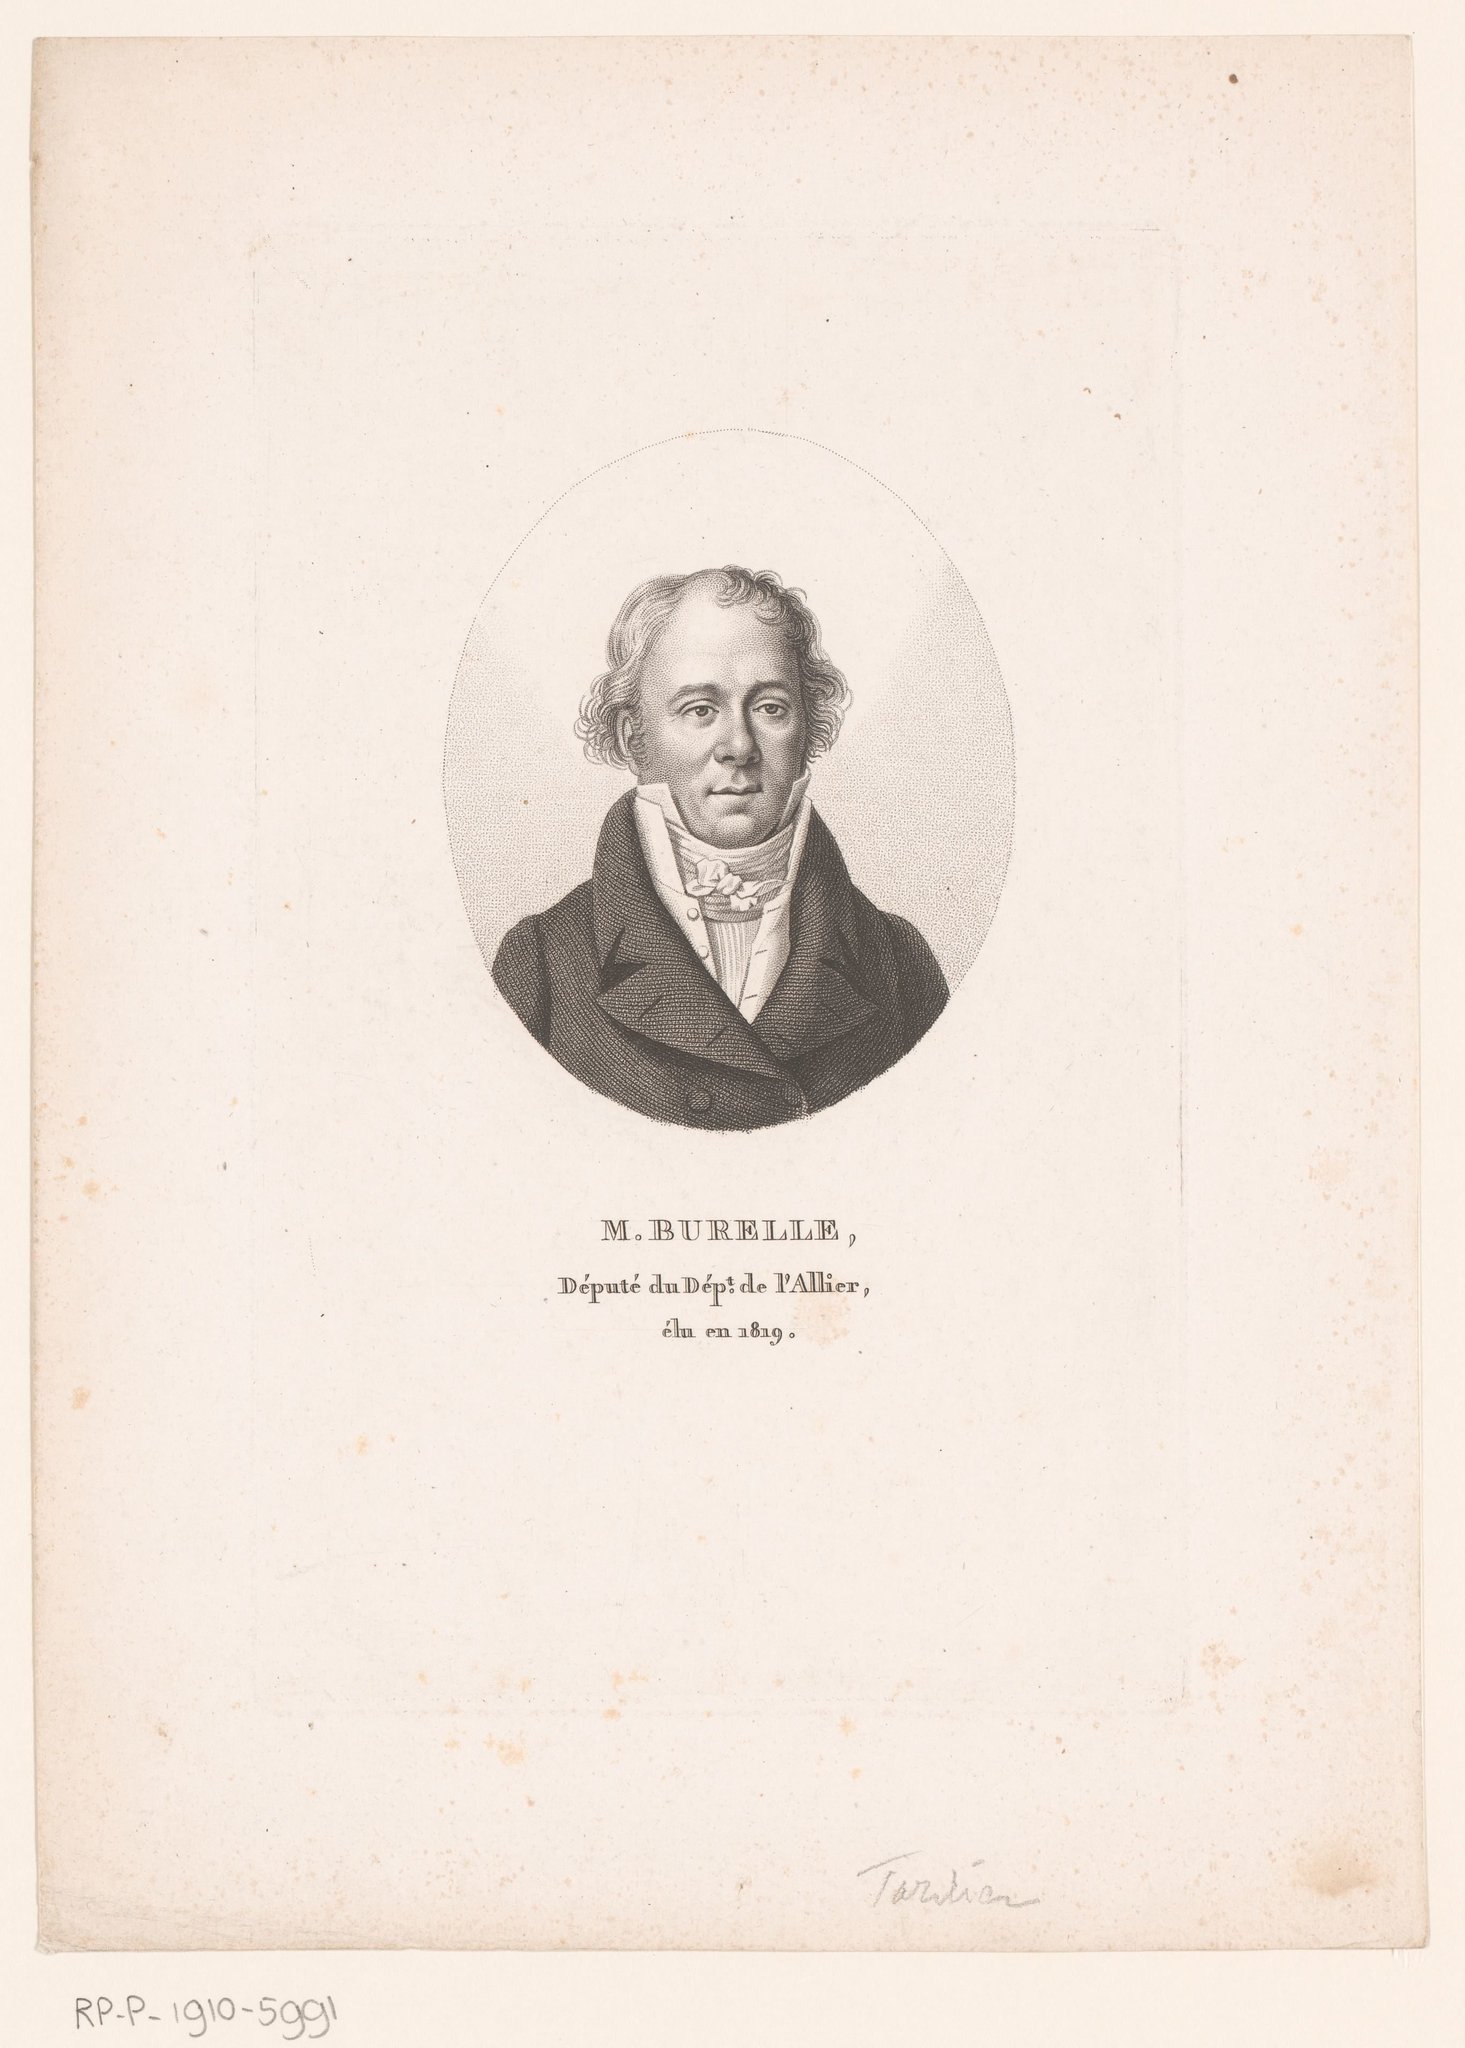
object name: print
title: Portret van Jean-François Burelle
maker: ambroise tardieu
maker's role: print maker, printer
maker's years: 1788-1841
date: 1820-1821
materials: paper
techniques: engraving, roulette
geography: paris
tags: historical persons, politician, e.g. party leader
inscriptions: collector's mark: Lugt 2228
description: Prent uit: Tardieu, Ambroise. Portraits des députés, écrivains et pairs constitutionnels, défenseurs invariables de la charte et de la loi des élections du 5 février 1817. Parijs: Tardieu, Ambroise, 1820-1821.